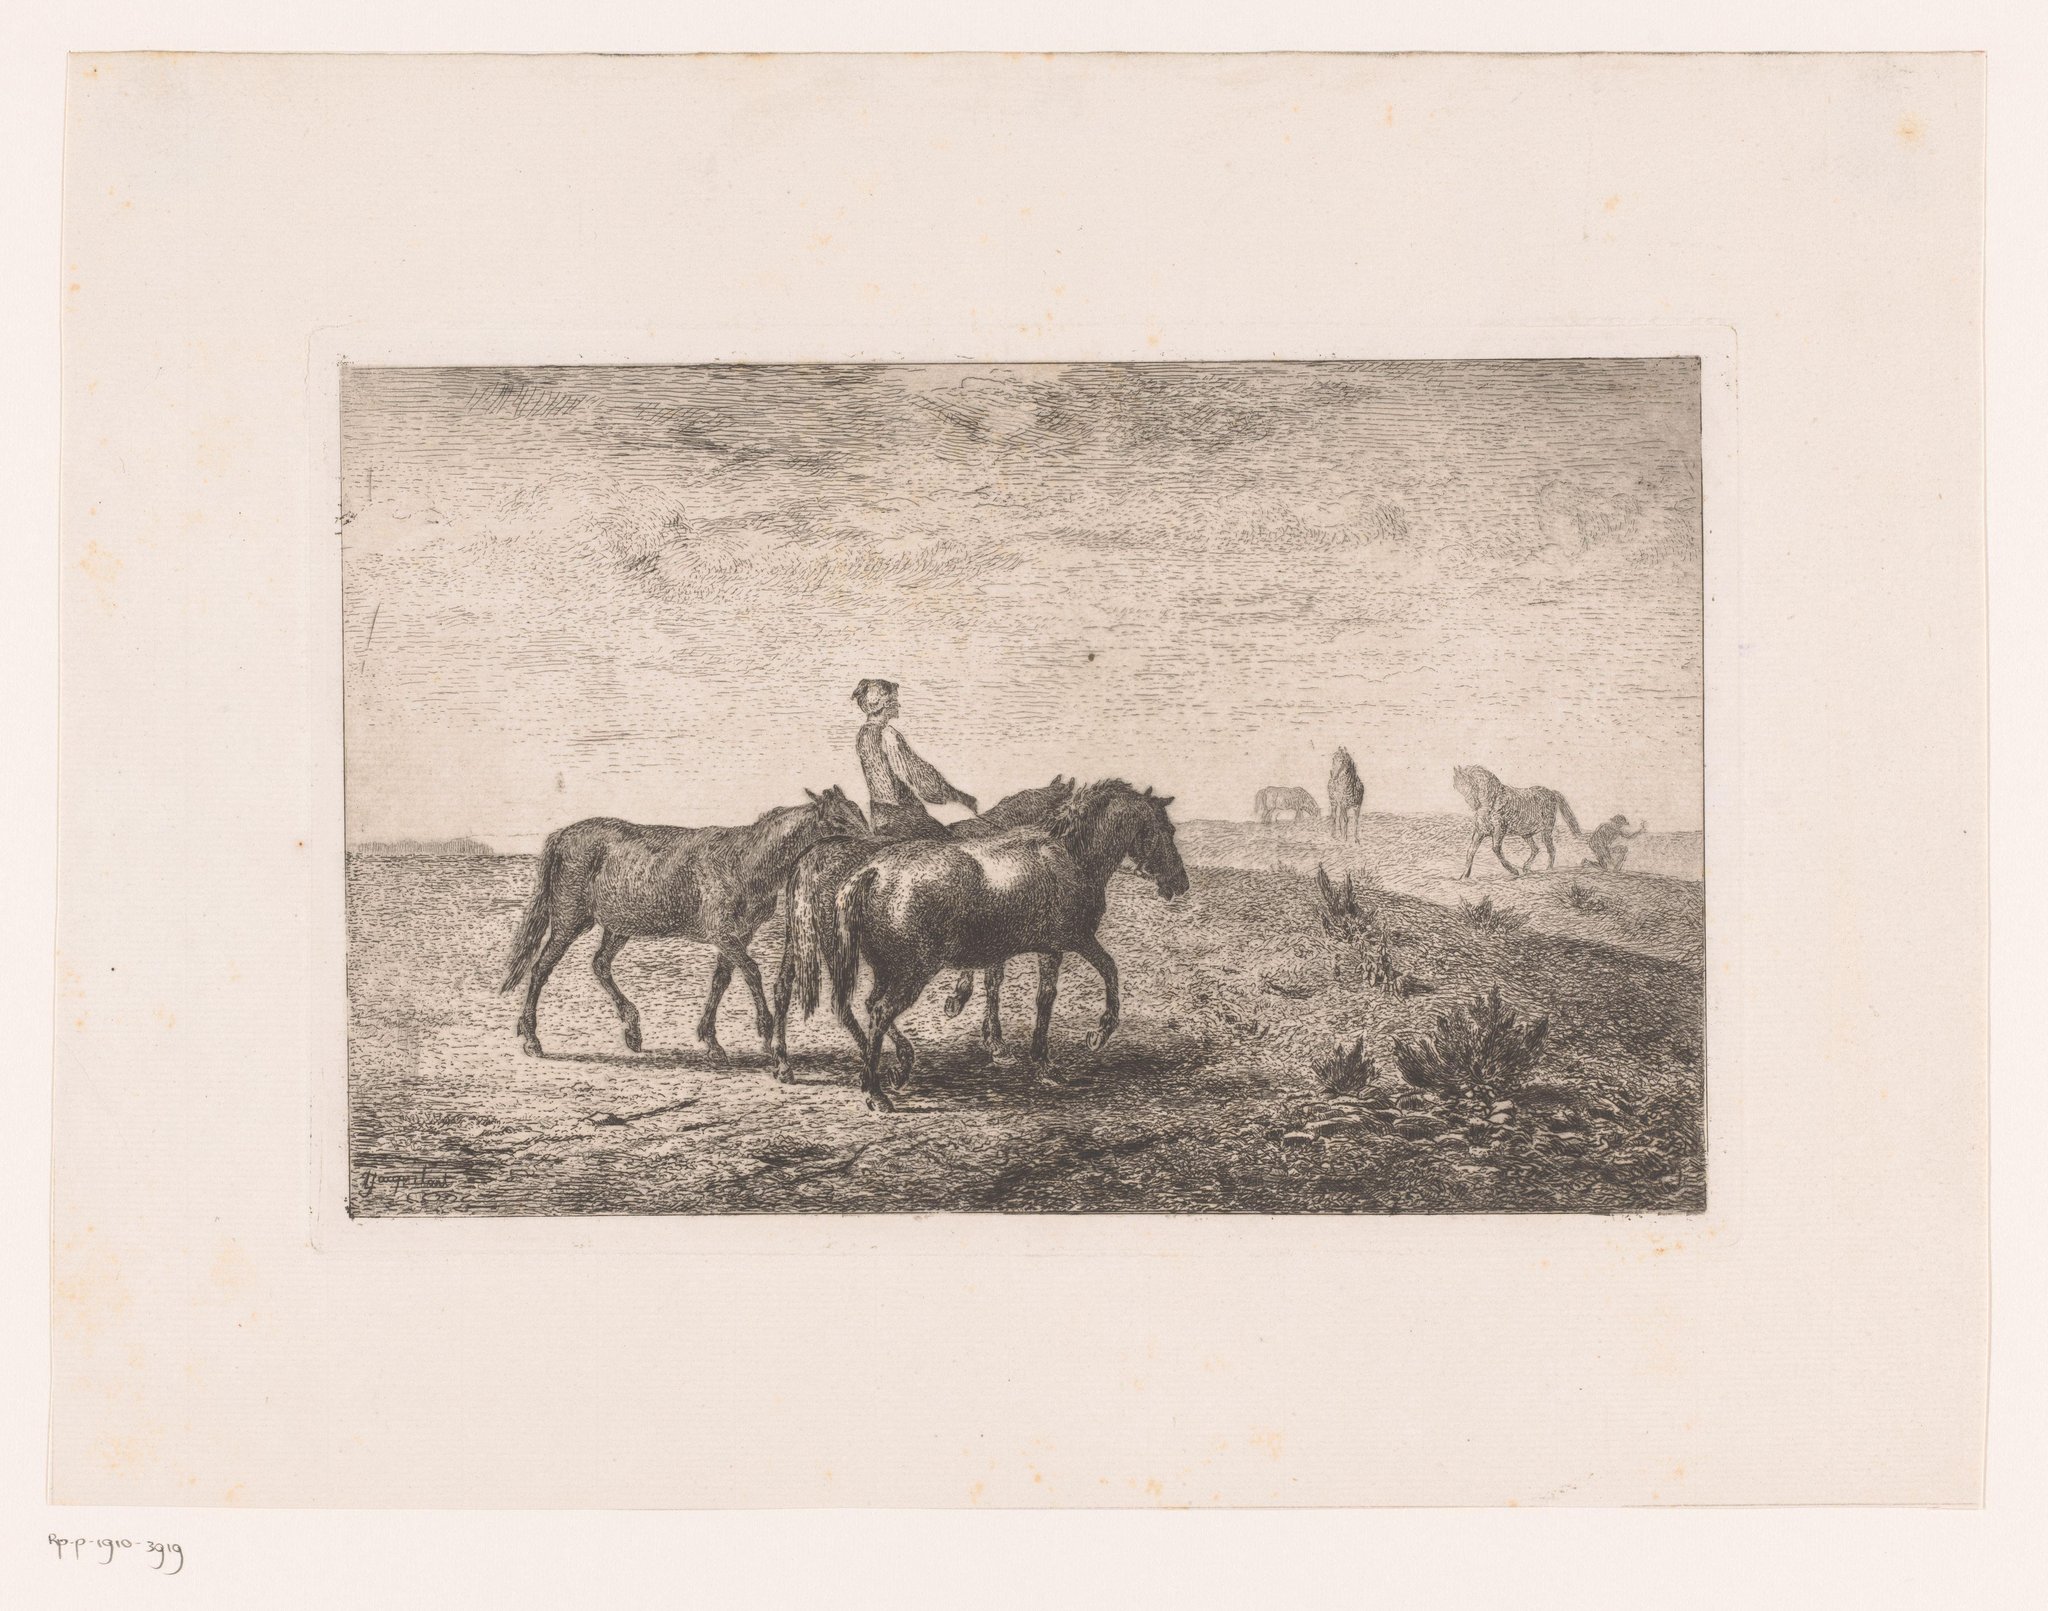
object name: print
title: Man leidt drie paarden door een weide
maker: lambert jacquelart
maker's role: print maker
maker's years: 1820-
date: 1830-1910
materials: paper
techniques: drypoint, etching, intaglio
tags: taming of wild horses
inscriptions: collector's mark: Lugt 2228